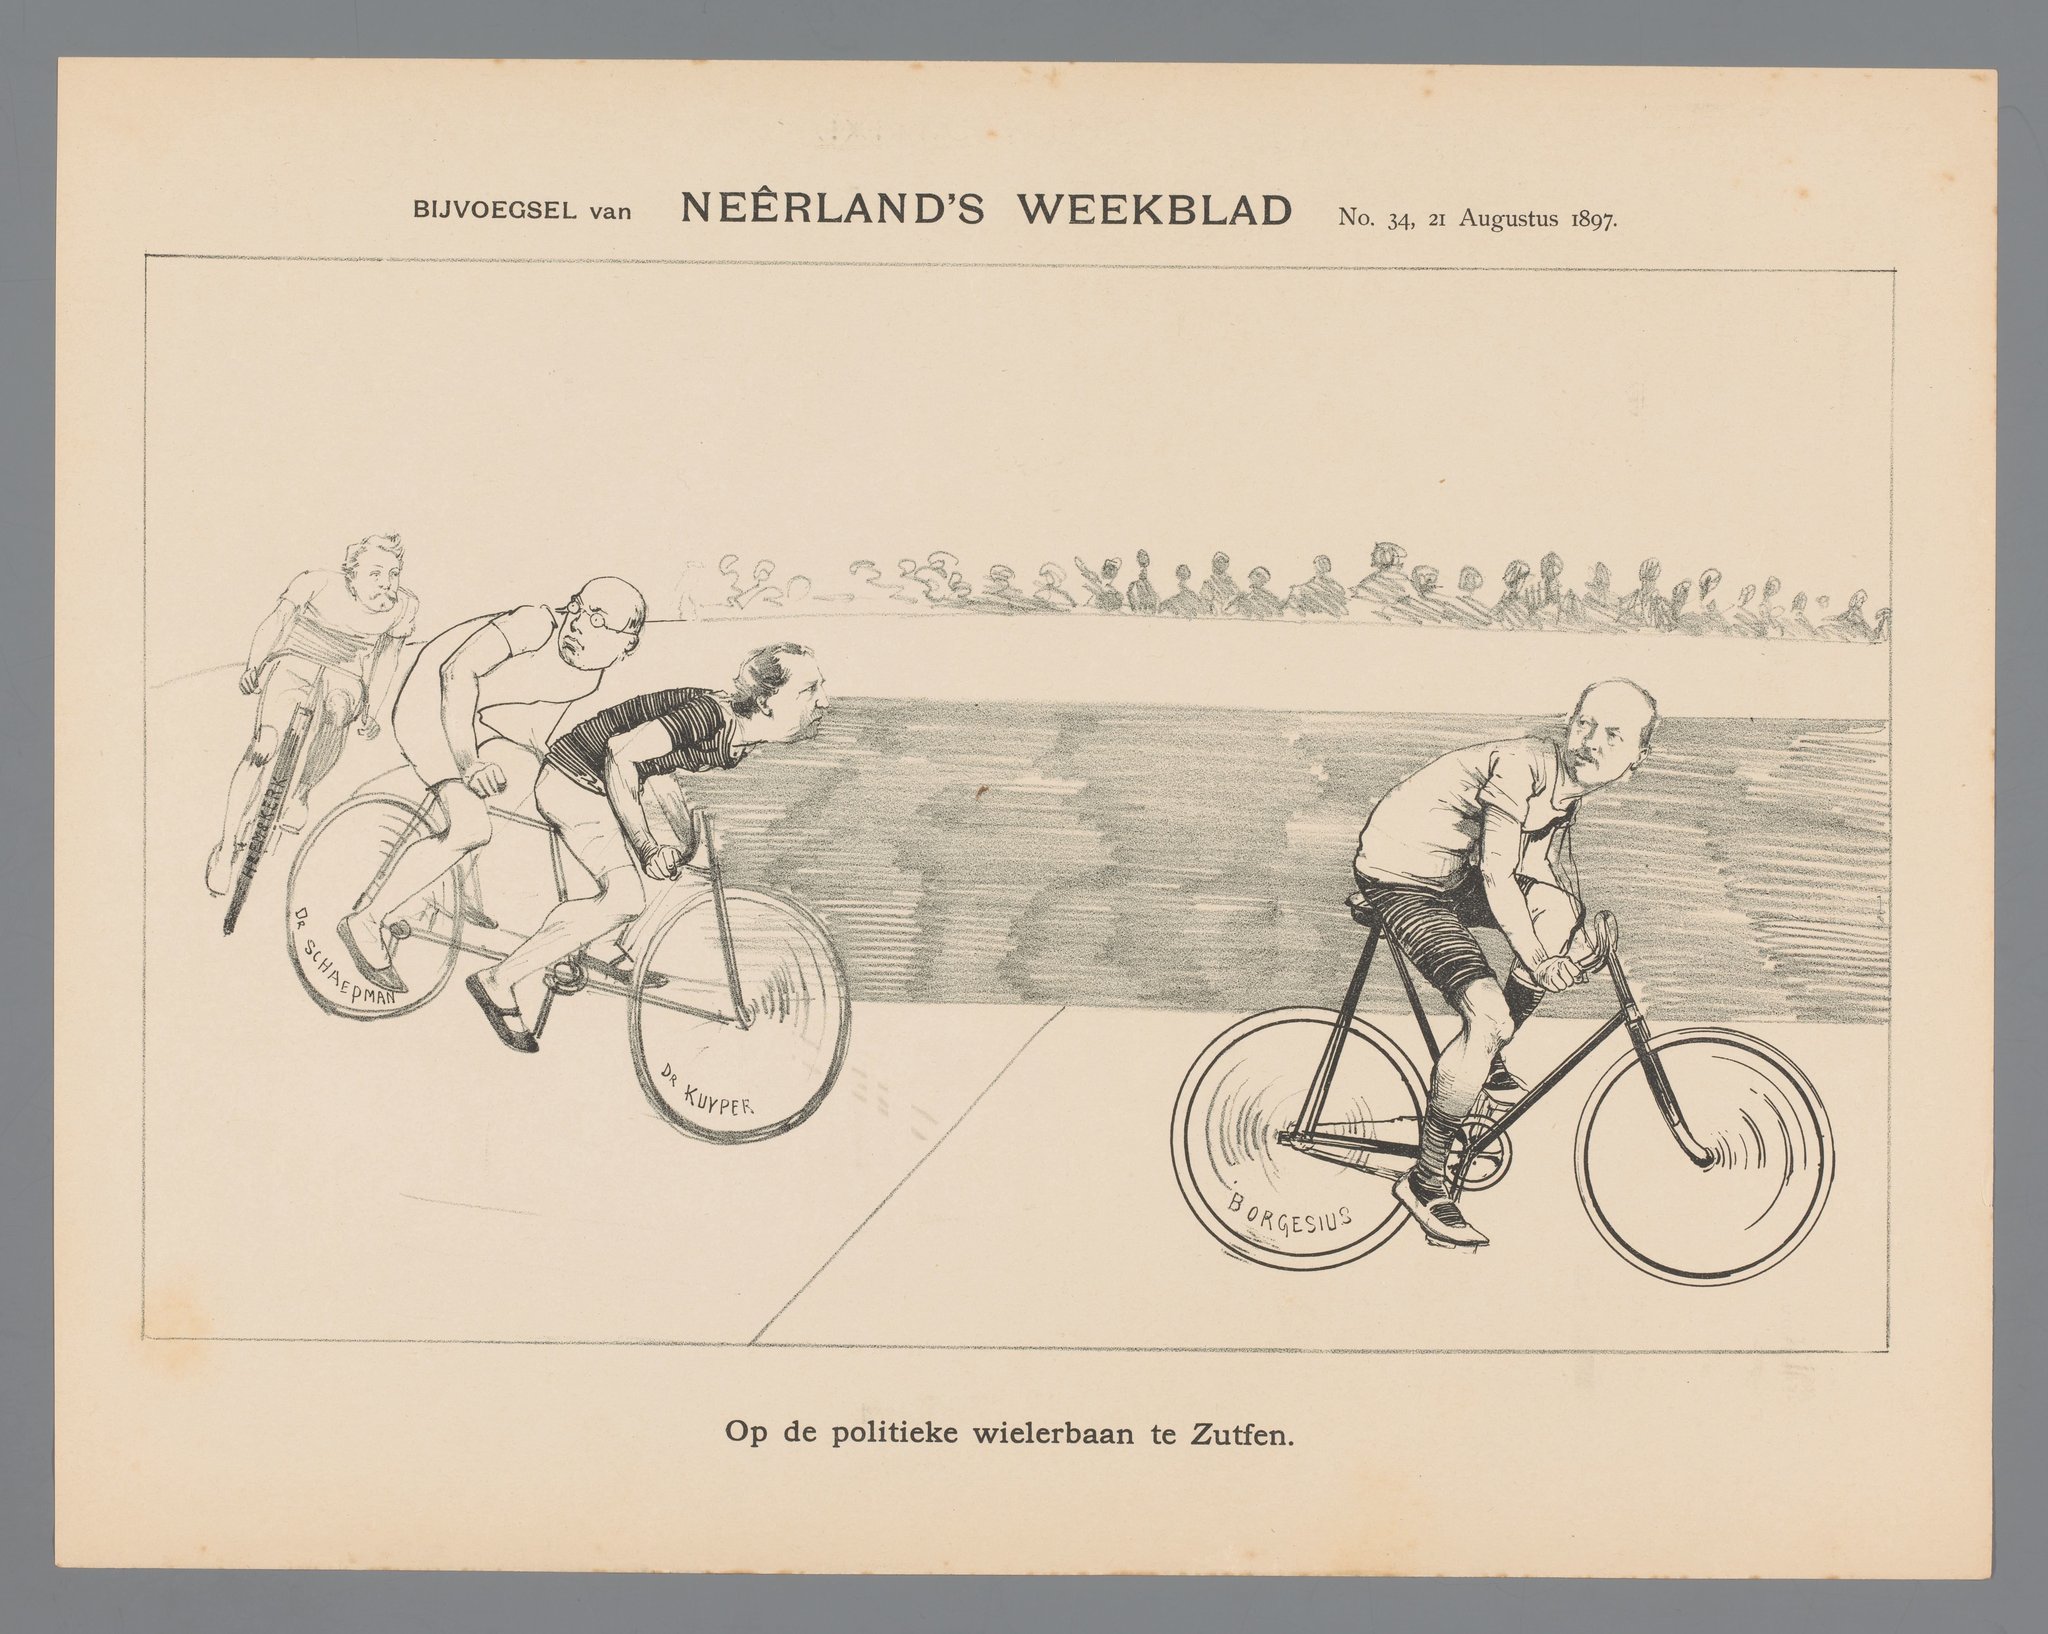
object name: cartoon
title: Op de politieke wielerbaan te Zutfen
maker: Anonymous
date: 1897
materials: paper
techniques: lithograph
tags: the hague, politician, amsterdam, utrecht, rome, priest, herman johannes aloysius maria schaepman, bicycle racing, historical persons, political caricatures and satires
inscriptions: date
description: Prent uit het bijvoegsel van: Neêrland’s Weekblad, nr. 34, 31 augustus 1897.